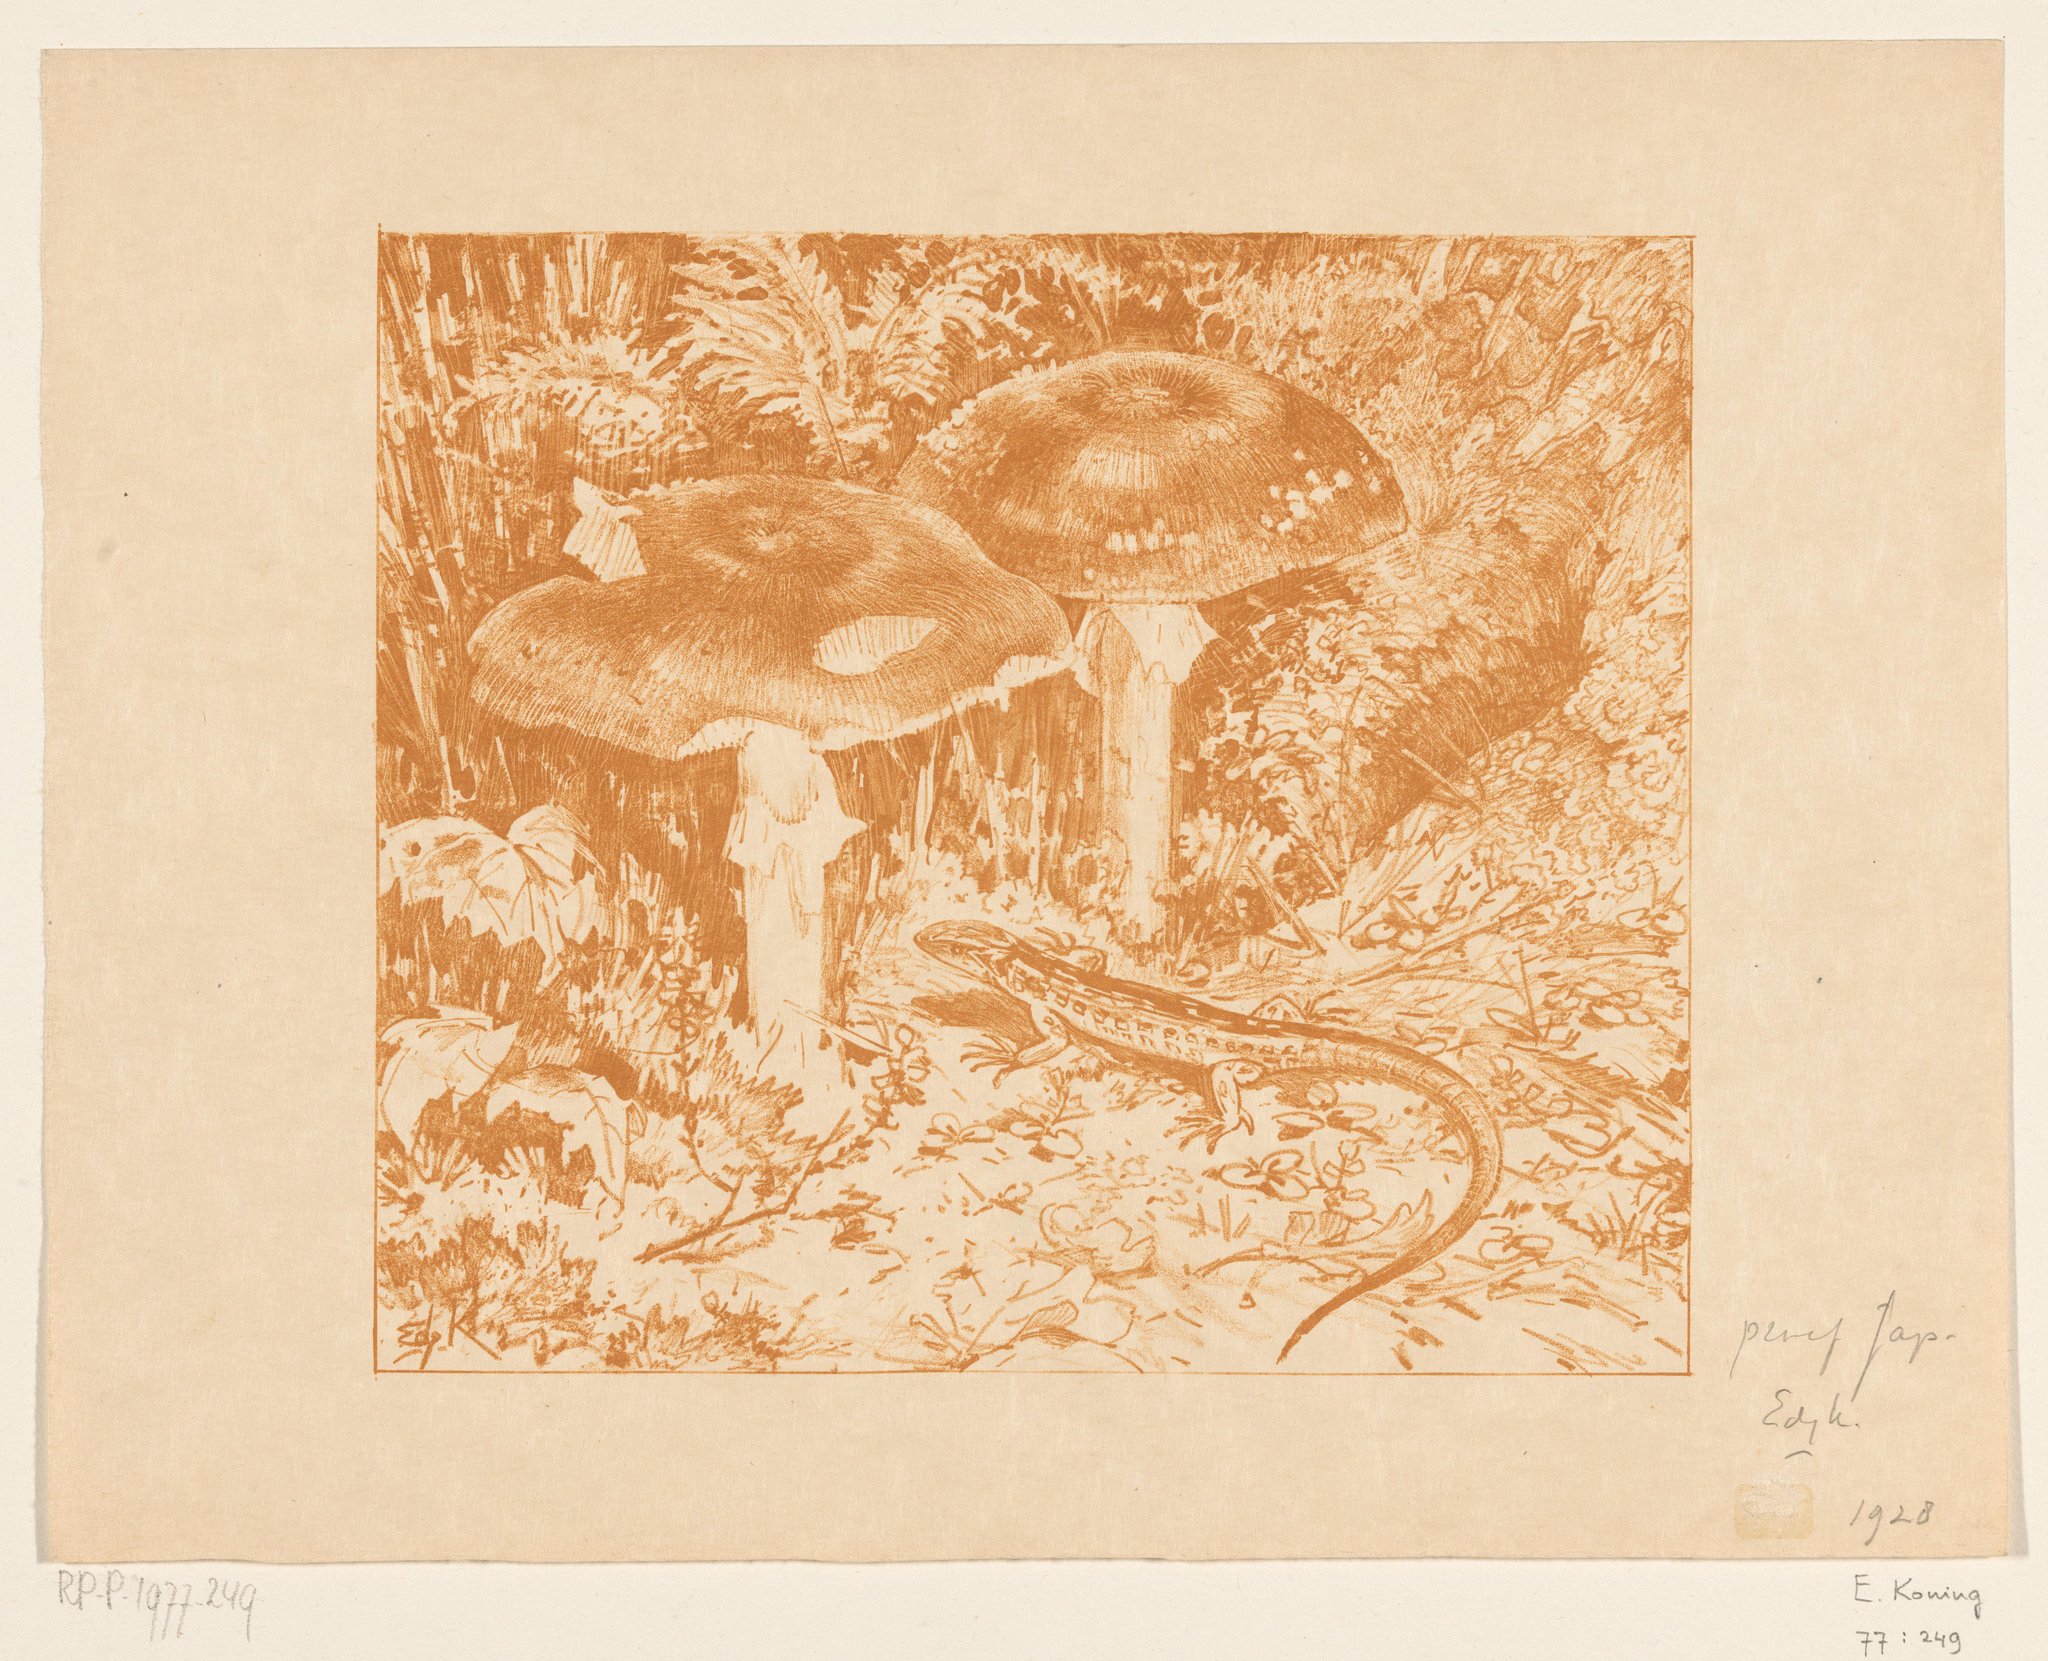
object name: print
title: Hagedis bij twee paddenstoelen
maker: edzard koning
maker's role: draughtsman, print maker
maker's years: 1869-1954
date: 1928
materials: paper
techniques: lithograph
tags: lizards, mushrooms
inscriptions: collector's mark: Lugt 2760, collector's mark: Lugt 2228